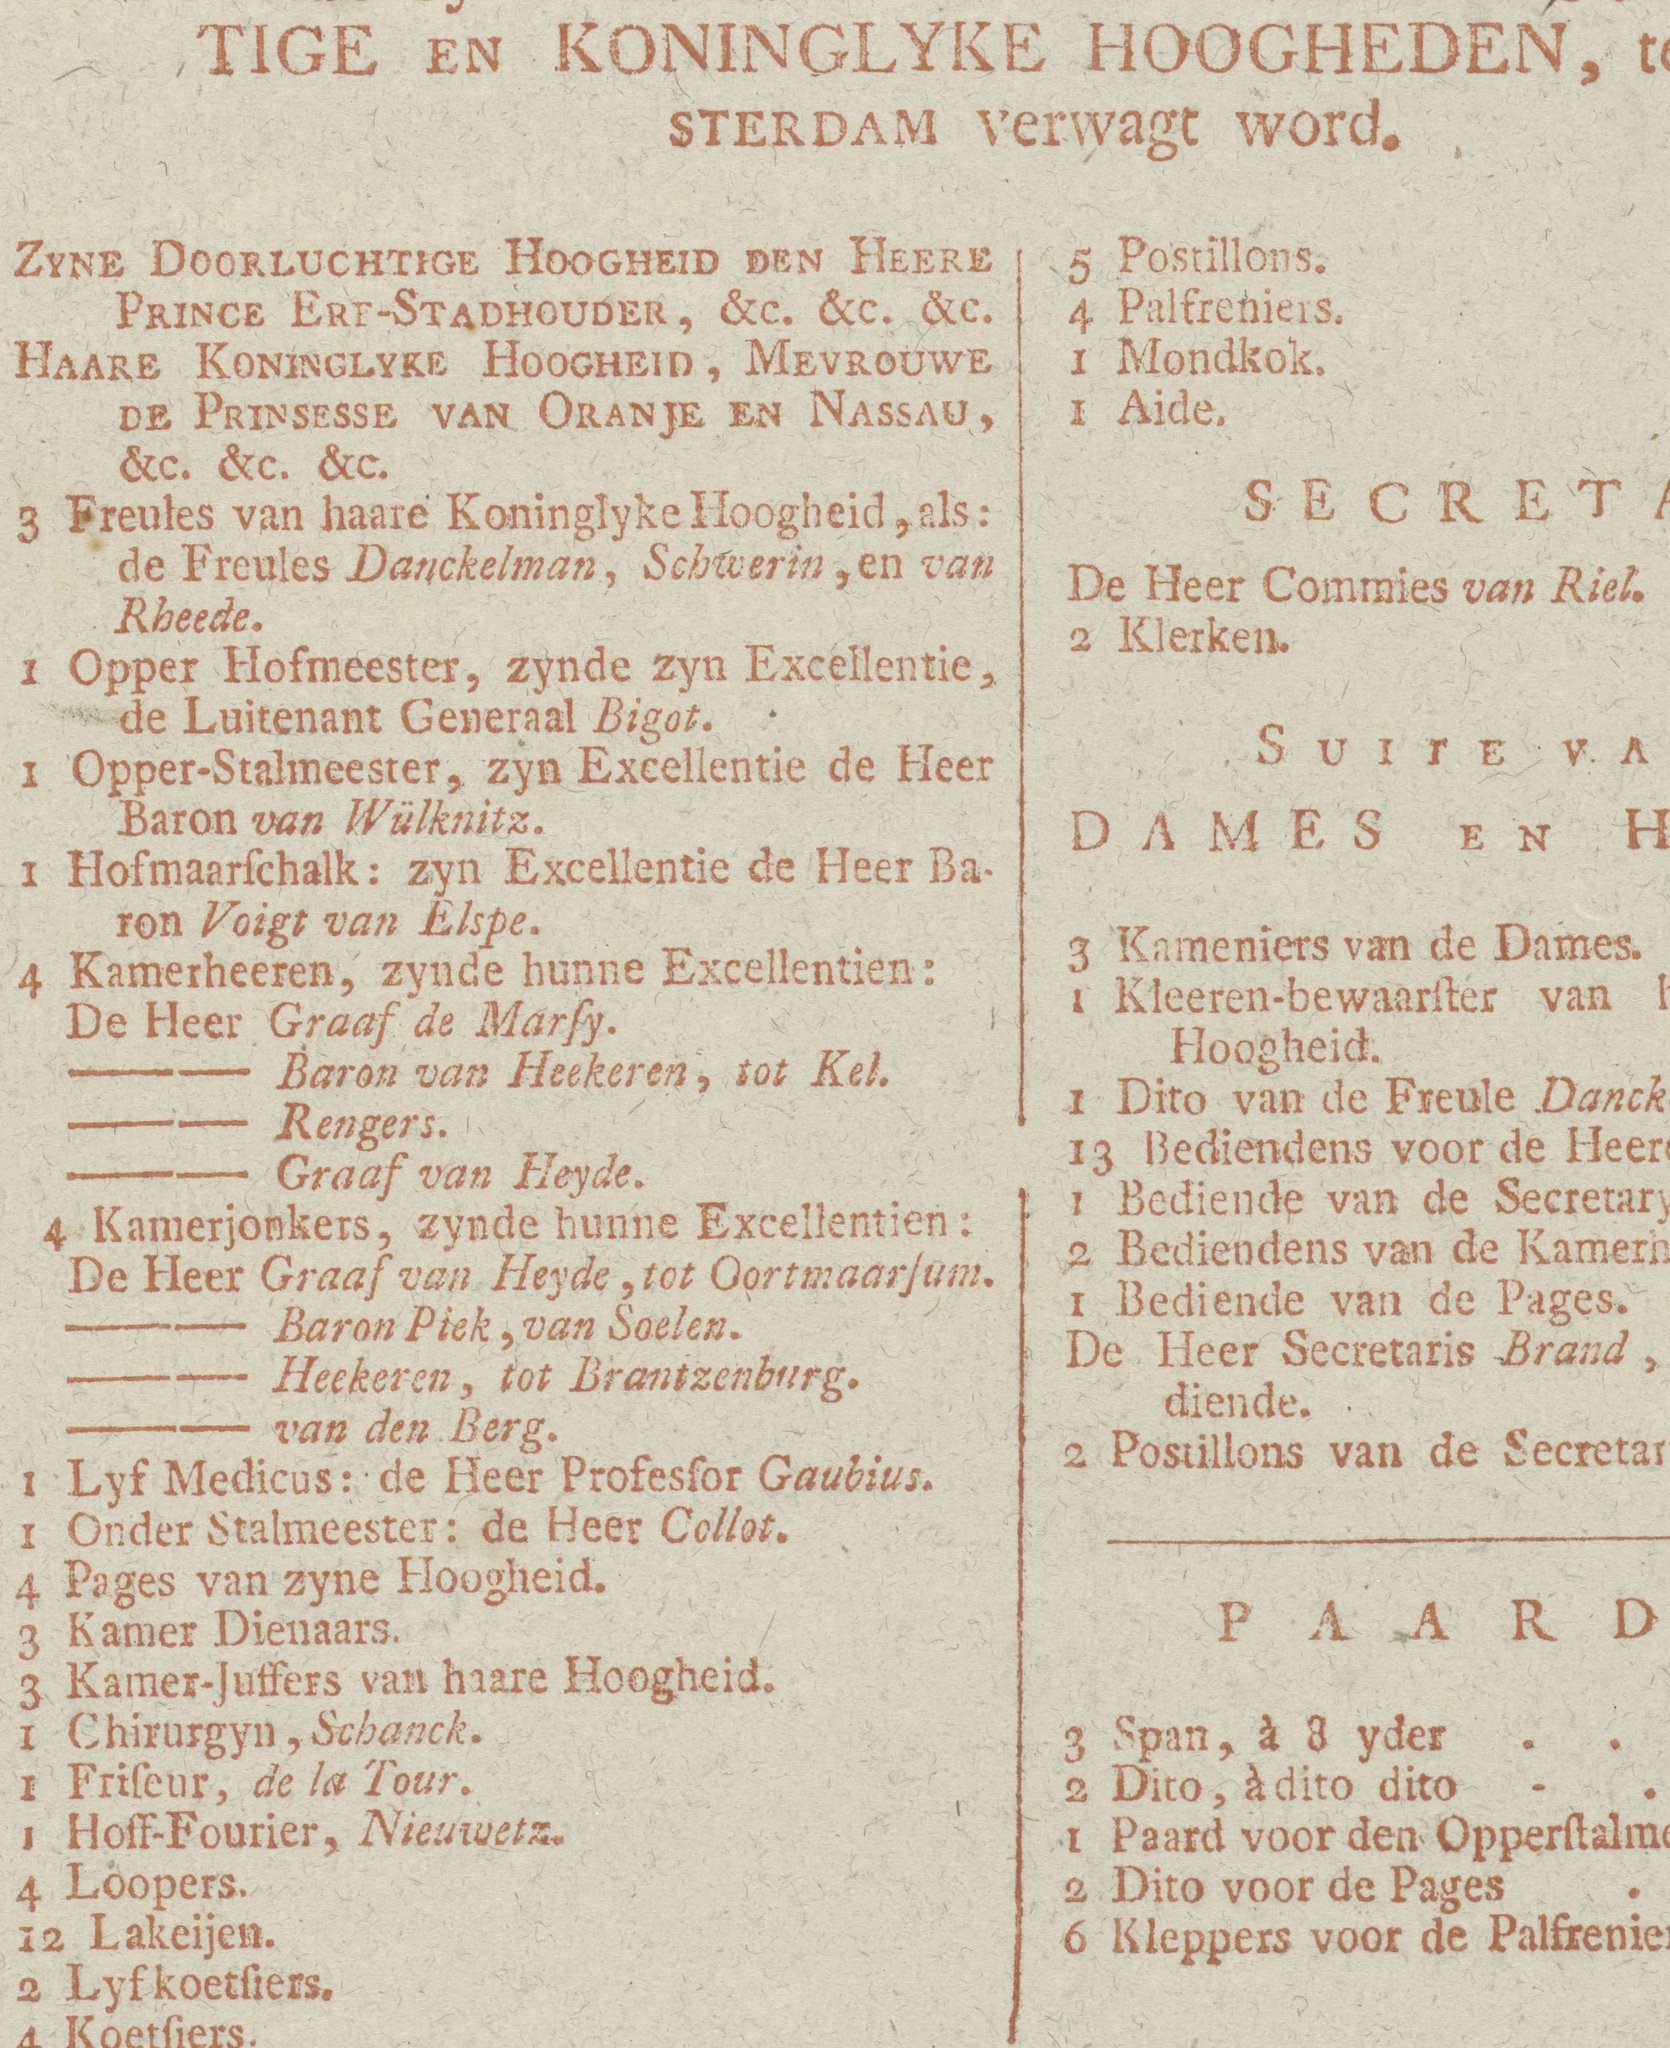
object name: text sheet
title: Lyst der Hof-Suite, Dewelke by 't aanstaande arrivement hunner Doorluchtige en Koninglyke Hoogheden, te Amsterdam verwagt word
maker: Anonymous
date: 1768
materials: paper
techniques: letterpress printing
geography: northern netherlands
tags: william v (prince of orange), painter, draughtsman, wilhelmina of prussia (princess of orange), amsterdam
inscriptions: collector's mark: Lugt 2228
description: Tekstblad met een lijst van de namen van de leden van de hofhouding die stadhouder Willem V en prinses Wilhelmina van Pruisen begeleiden bij hun bezoek aan Amsterdam, 30 mei - 4 juni 1768. Blad met tekst gedrukt in rood in twee kolommen.